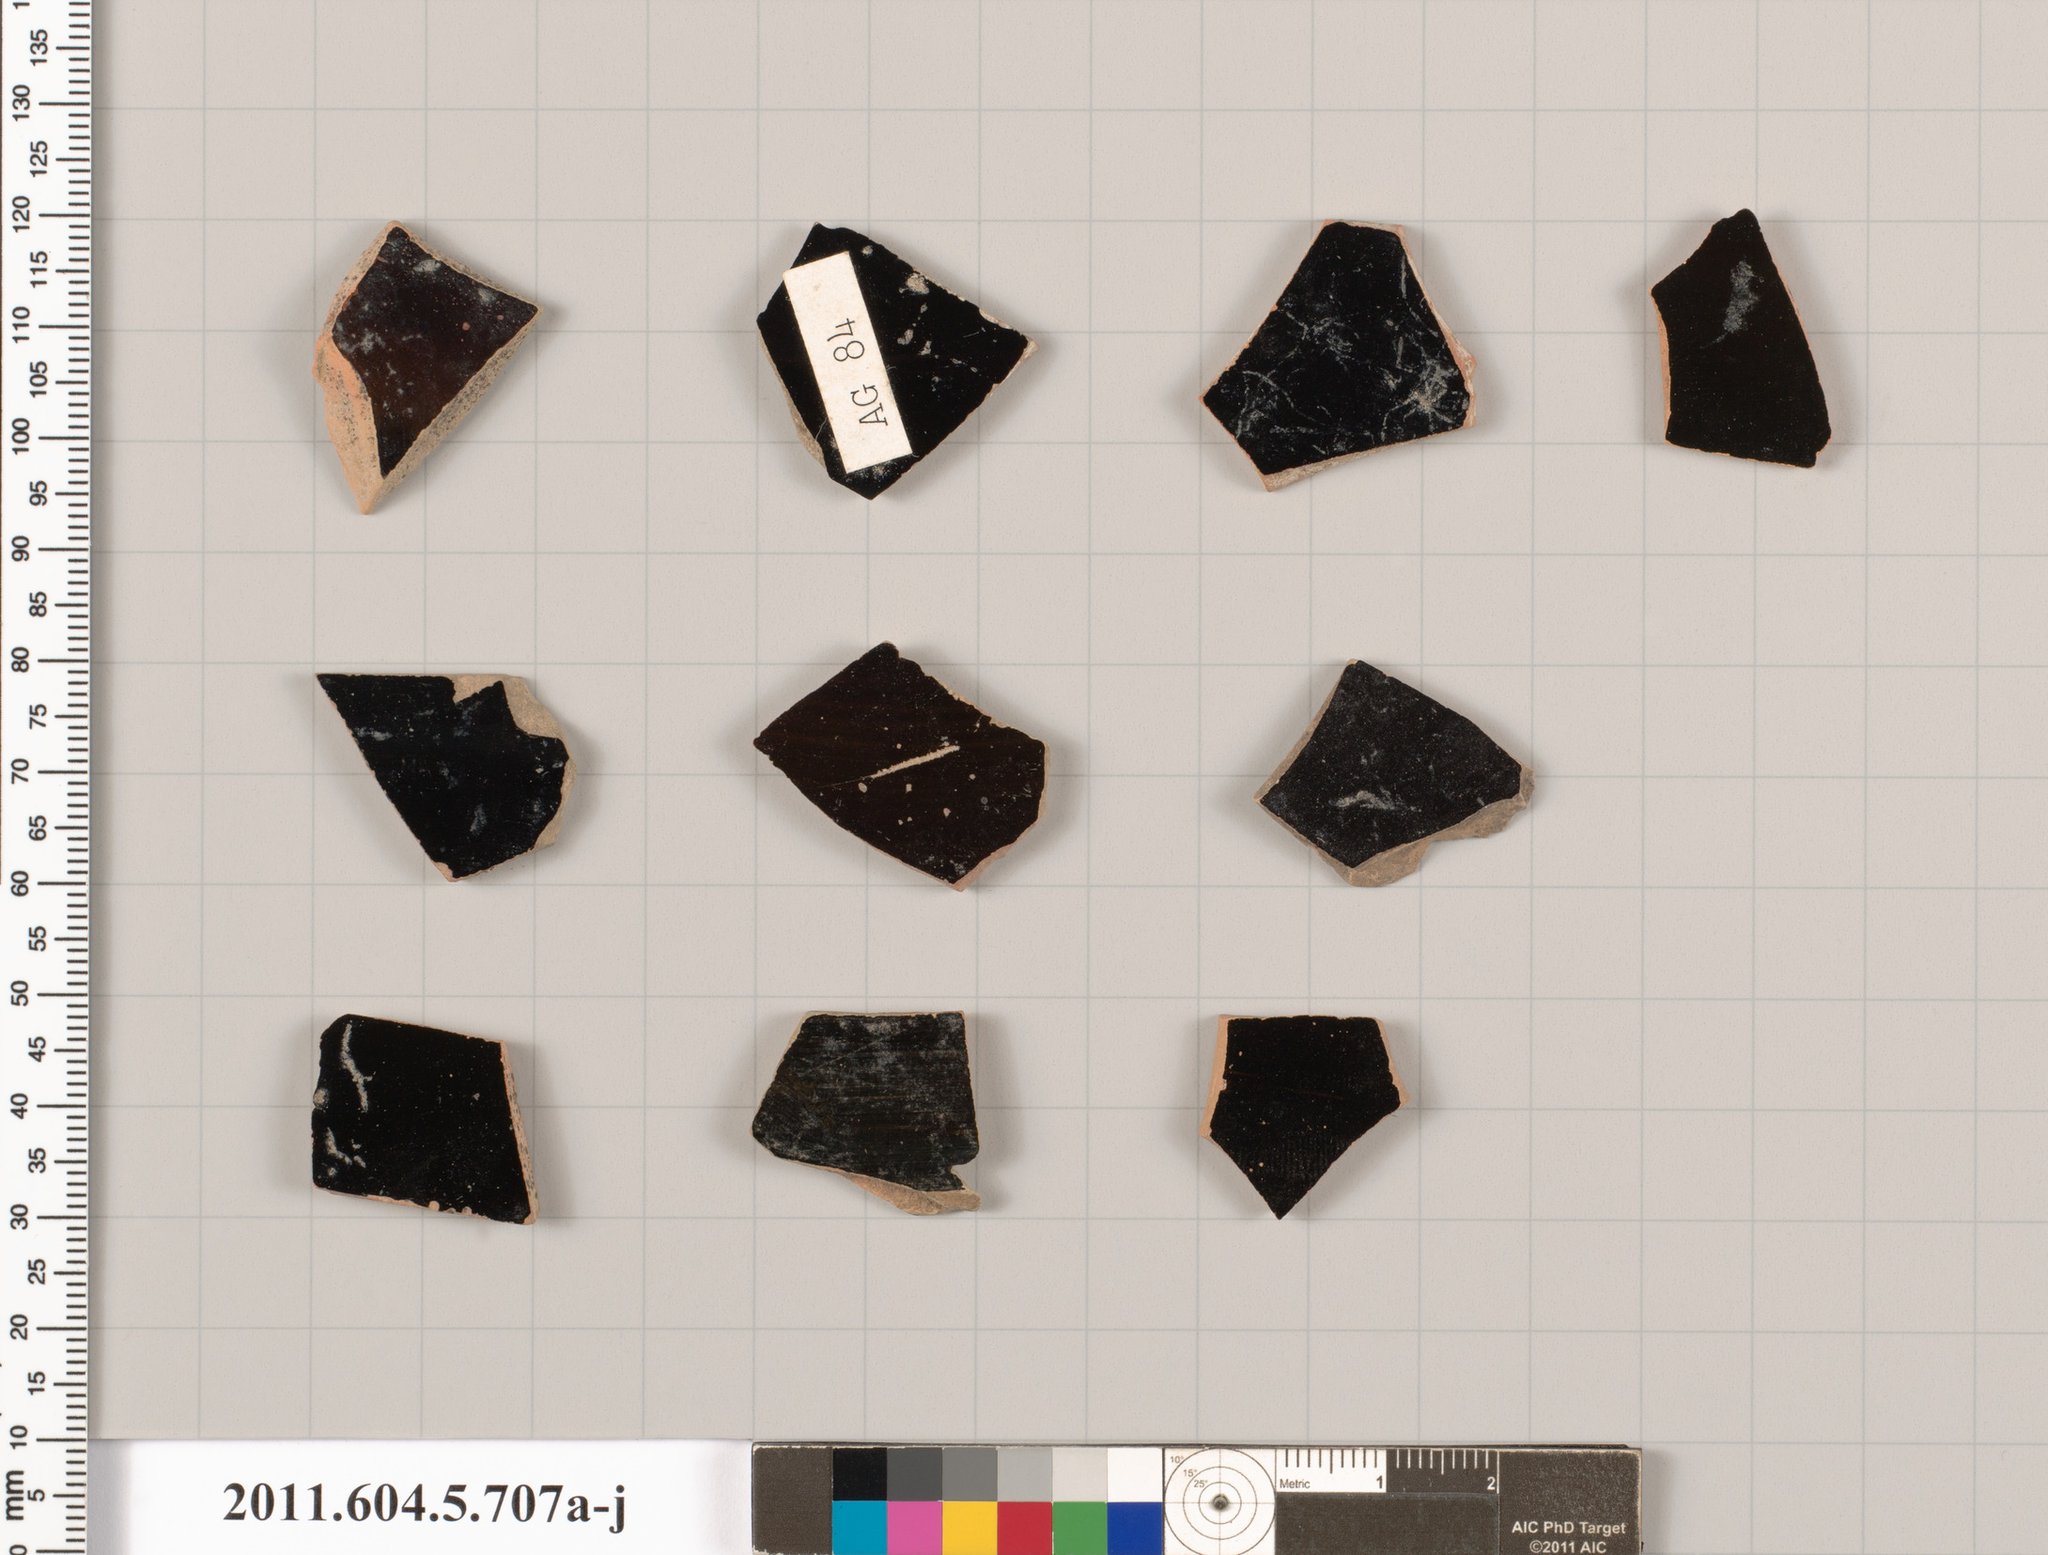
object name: kylix fragment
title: Terracotta fragments of kylikes (drinking cups)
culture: greek, attic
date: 600-401 BCE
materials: terracotta